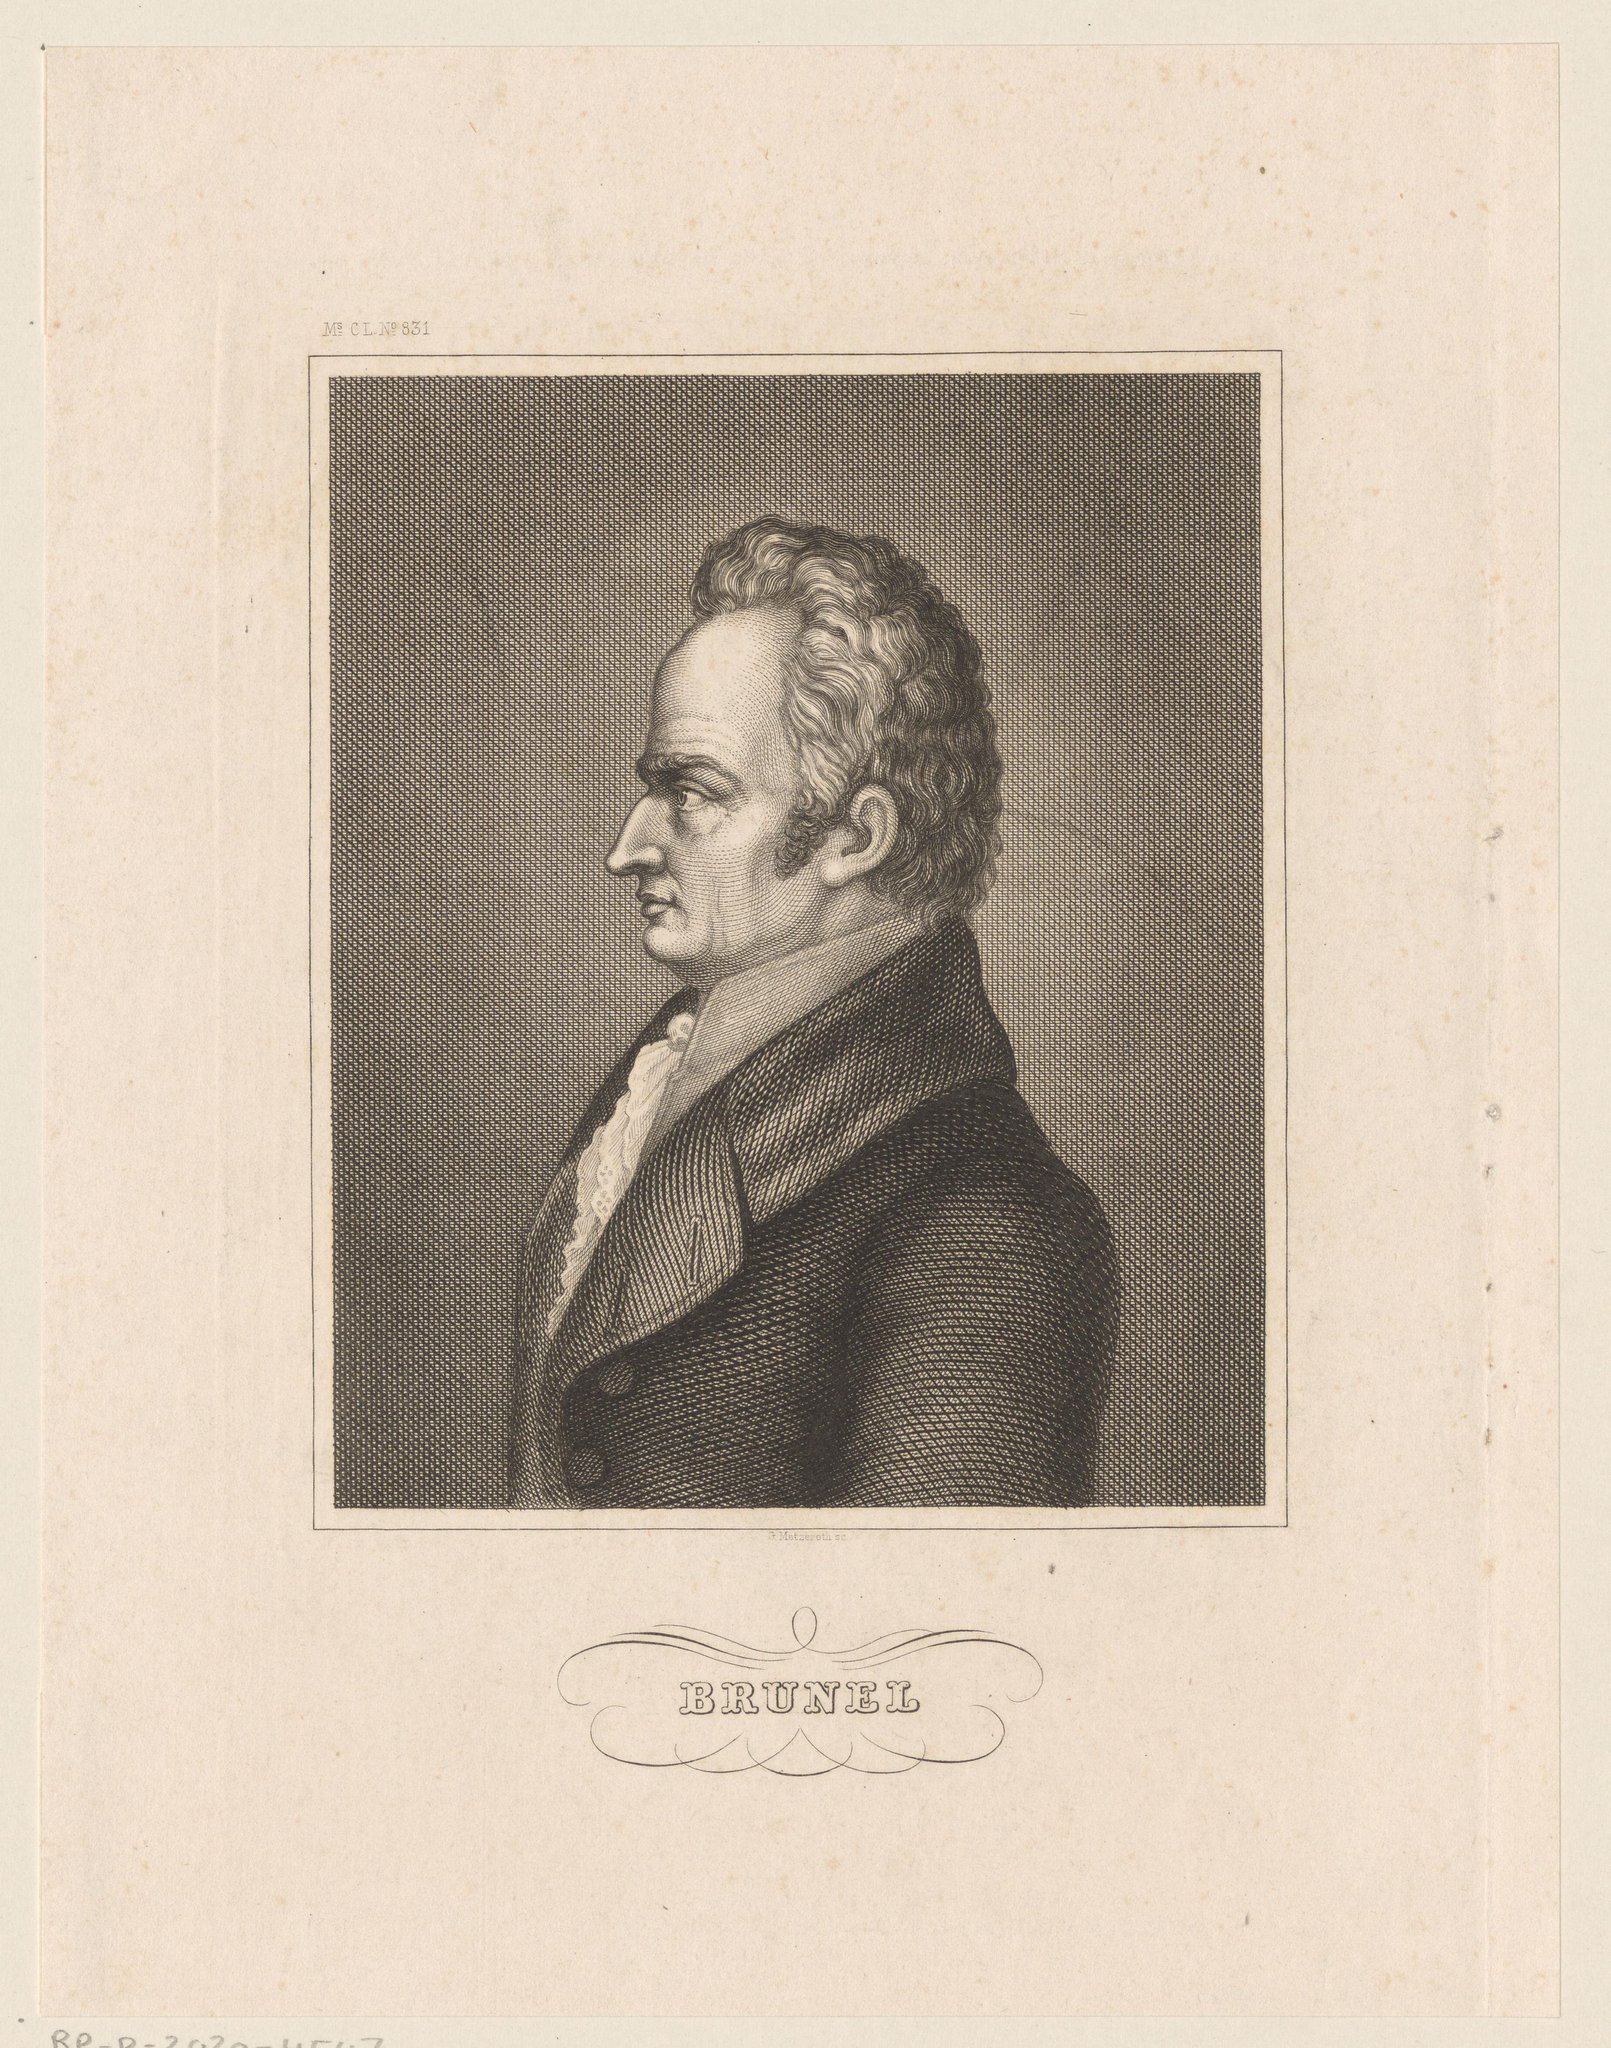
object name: book illustration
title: Portret van Marc Isambard Brunel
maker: g. metzeroth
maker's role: print maker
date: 1840-1855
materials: paper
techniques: engraving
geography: hildburghausen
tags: london, historical persons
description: Prent uit: Meyer, Joseph. Das Grosse Conversations-Lexikon für die gebildeten Stände. Hildburghausen: Bibliographisches Institut, 1840-1855.